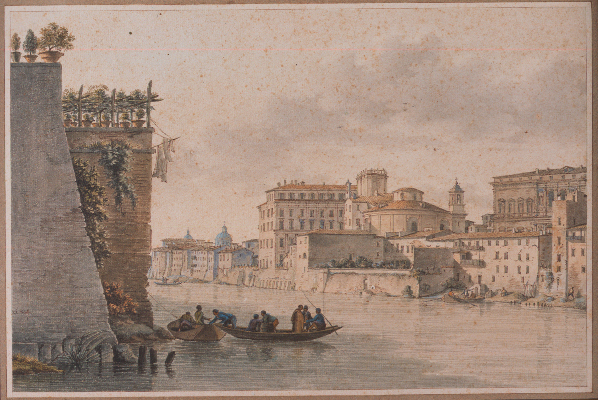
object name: drawing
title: View of the Tiber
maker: victor jean nicolle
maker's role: artist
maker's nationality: french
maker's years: 1754-1826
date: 1789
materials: ink, paper, watercolor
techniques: pen, wash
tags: cities,rivers,boats